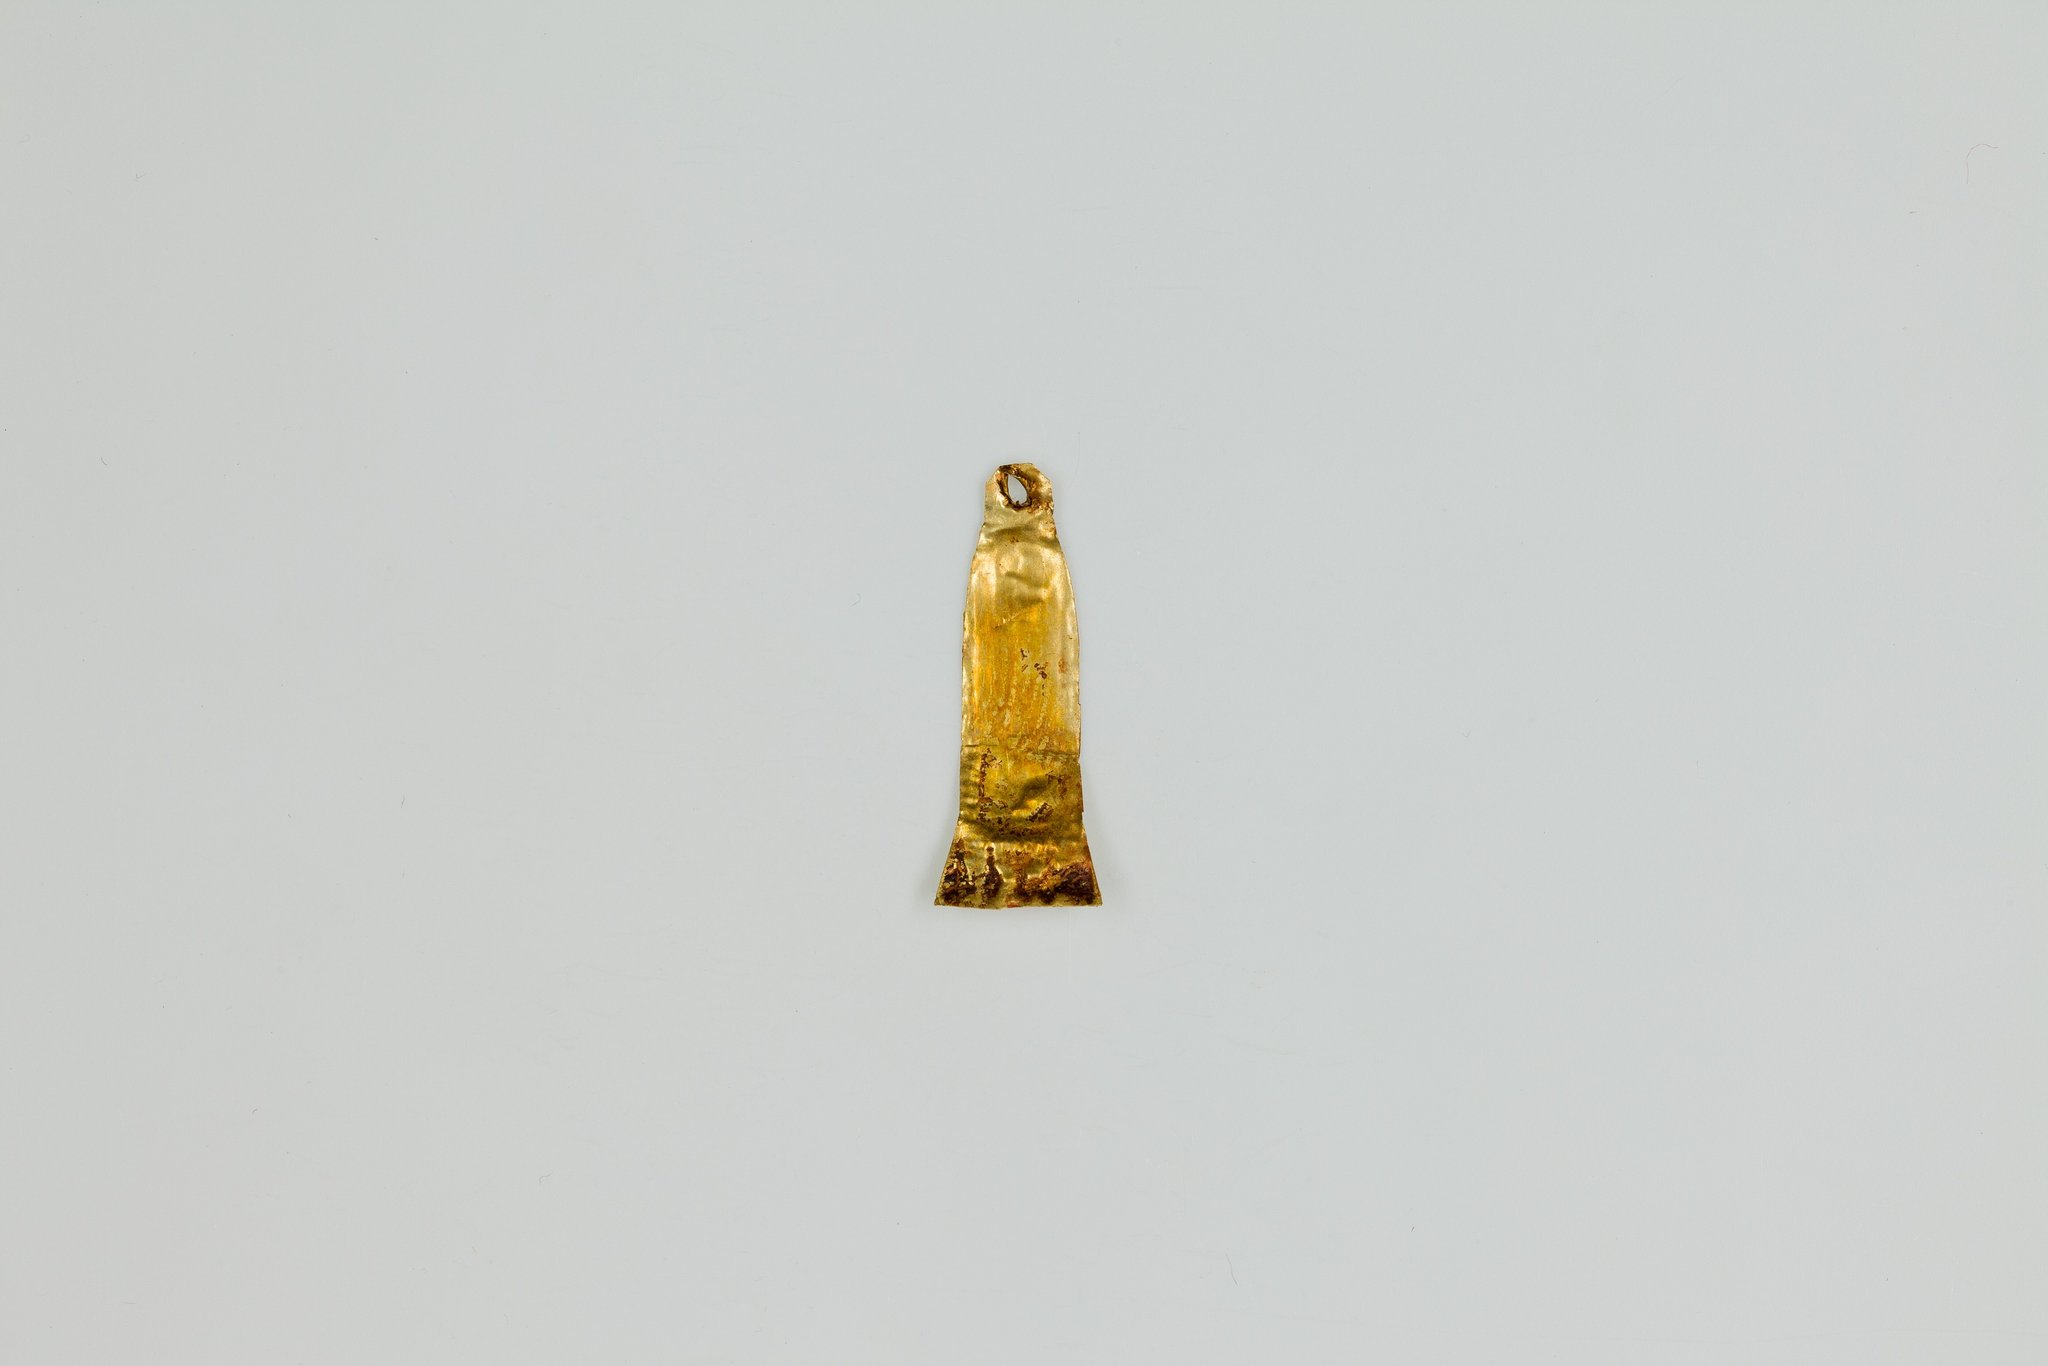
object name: amulet, aper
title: Aper amulet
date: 664-380 BCE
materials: gold